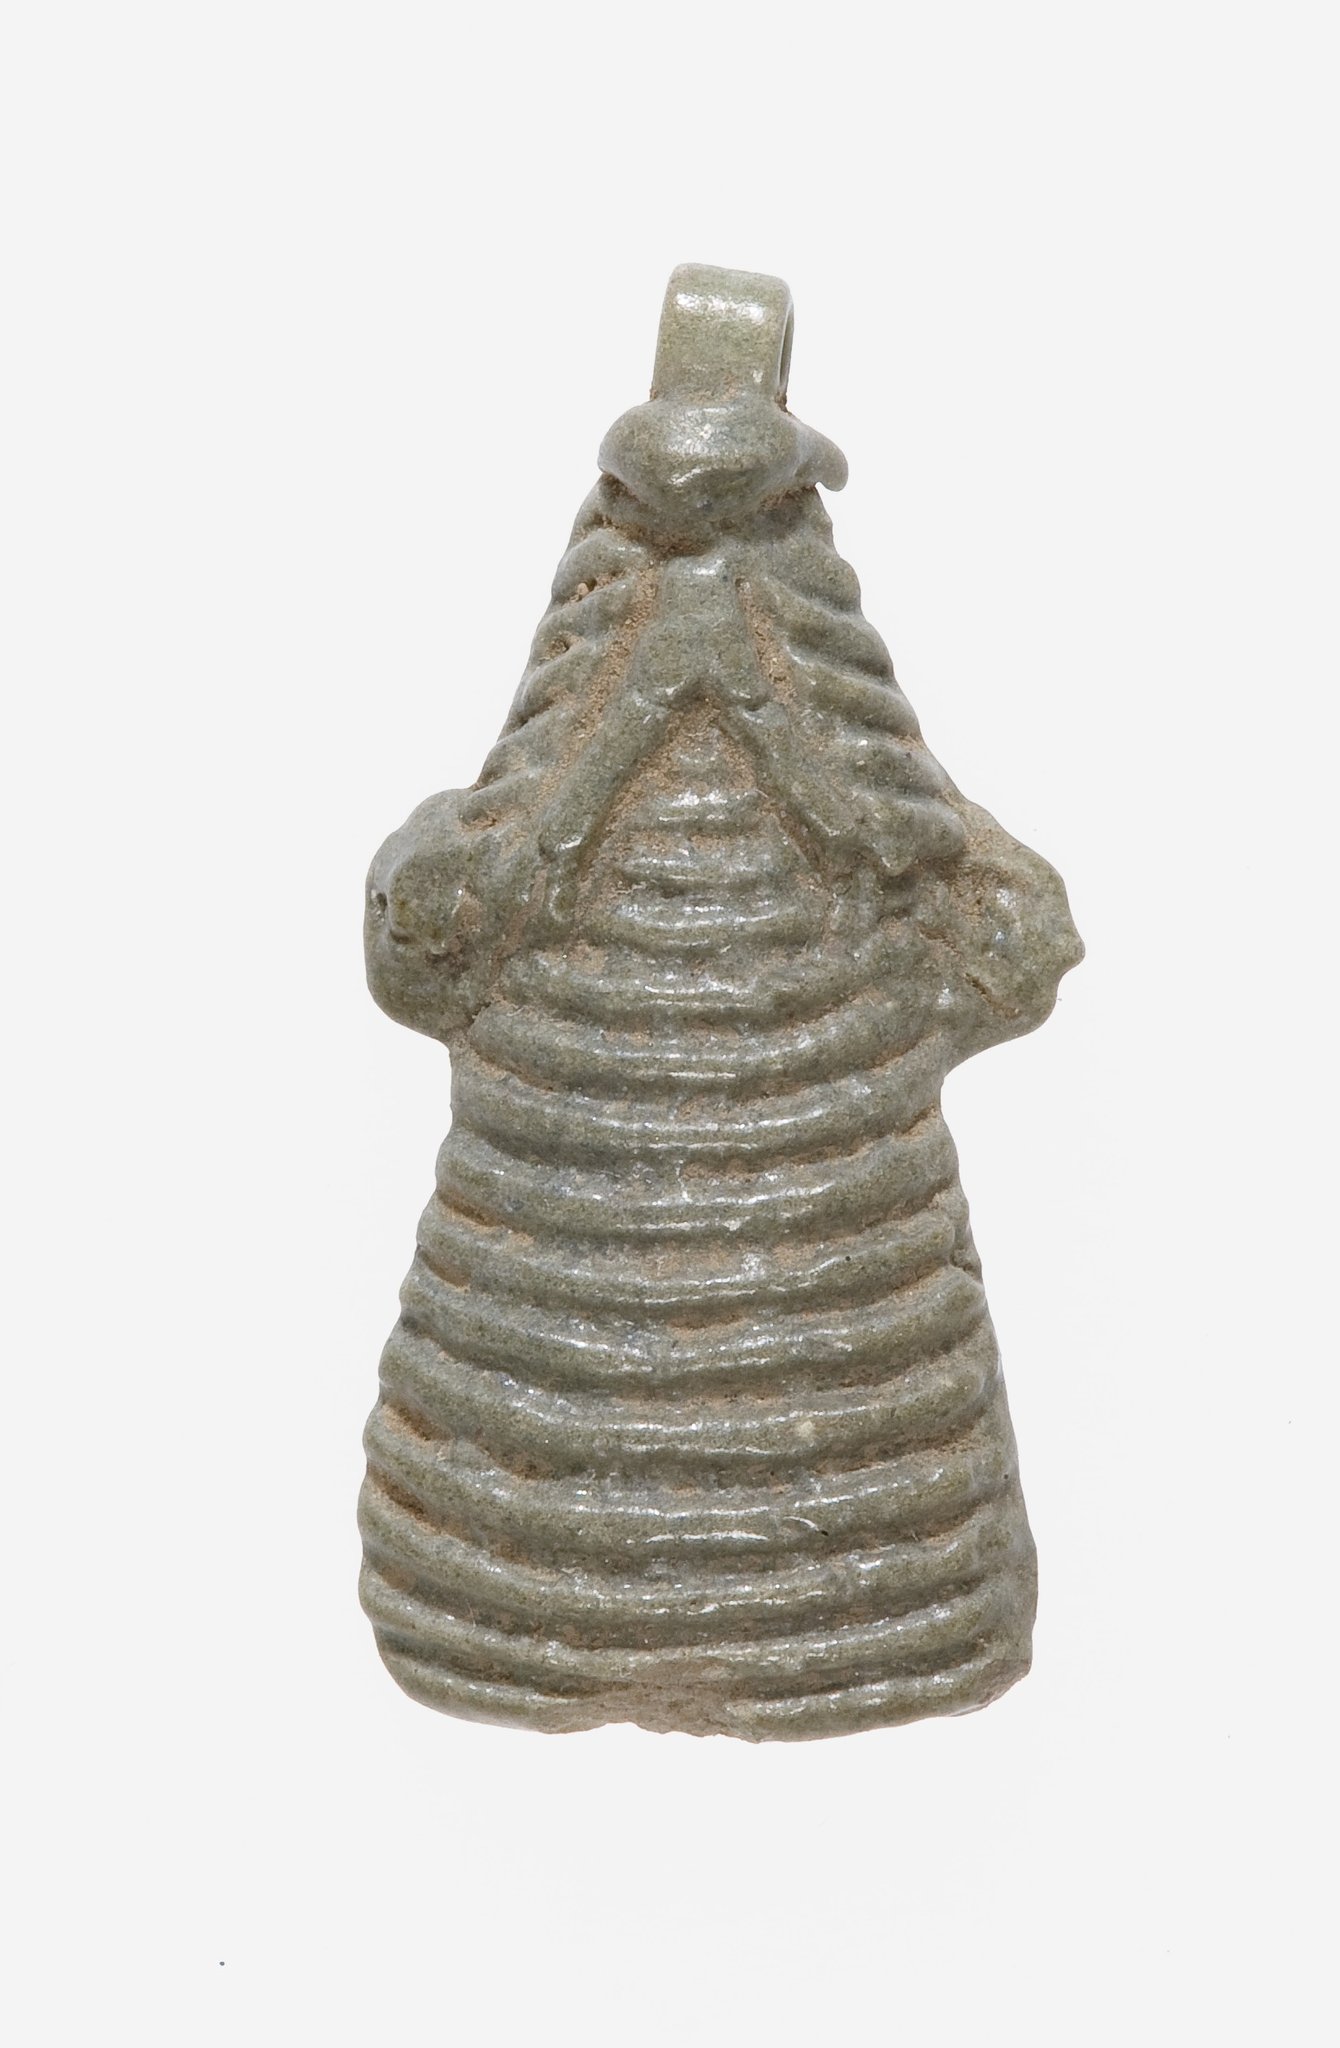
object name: pendant, lily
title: Lily Pendant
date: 1390-1352 BCE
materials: faience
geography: egypt